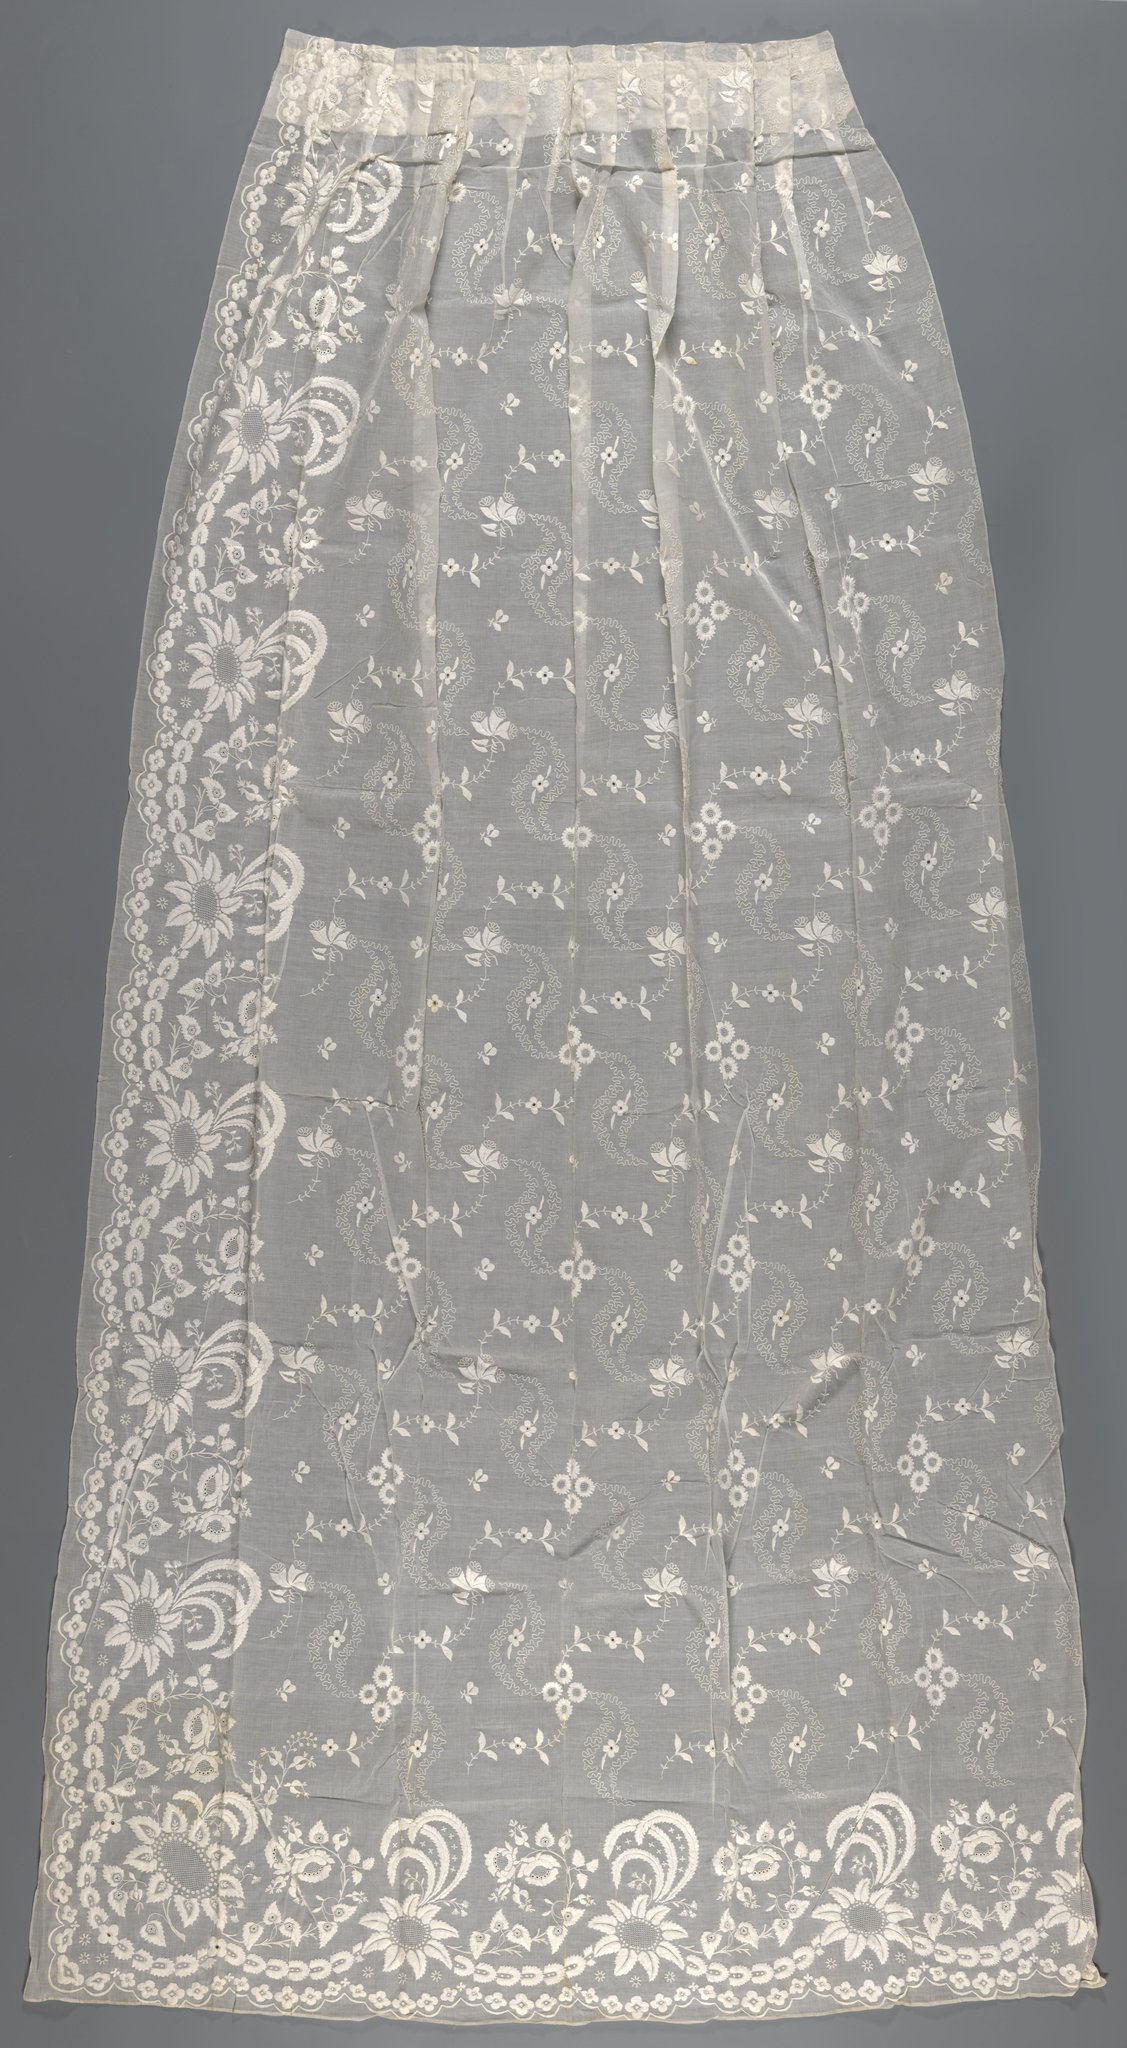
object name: curtain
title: Gordijn van glasbatist versierd met tule doorstopborduursel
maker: Anonymous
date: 1800-1874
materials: textile, copper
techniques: stopwork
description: Gordijn van glasbatist, versierd met tule doorstopborduursel (wit op wit) in de vorm van margrieten en andere bloemen. Aangenaaid band met koperen ringen. Onderaan met potlood gemerkt: 105 18/4 4 (?).